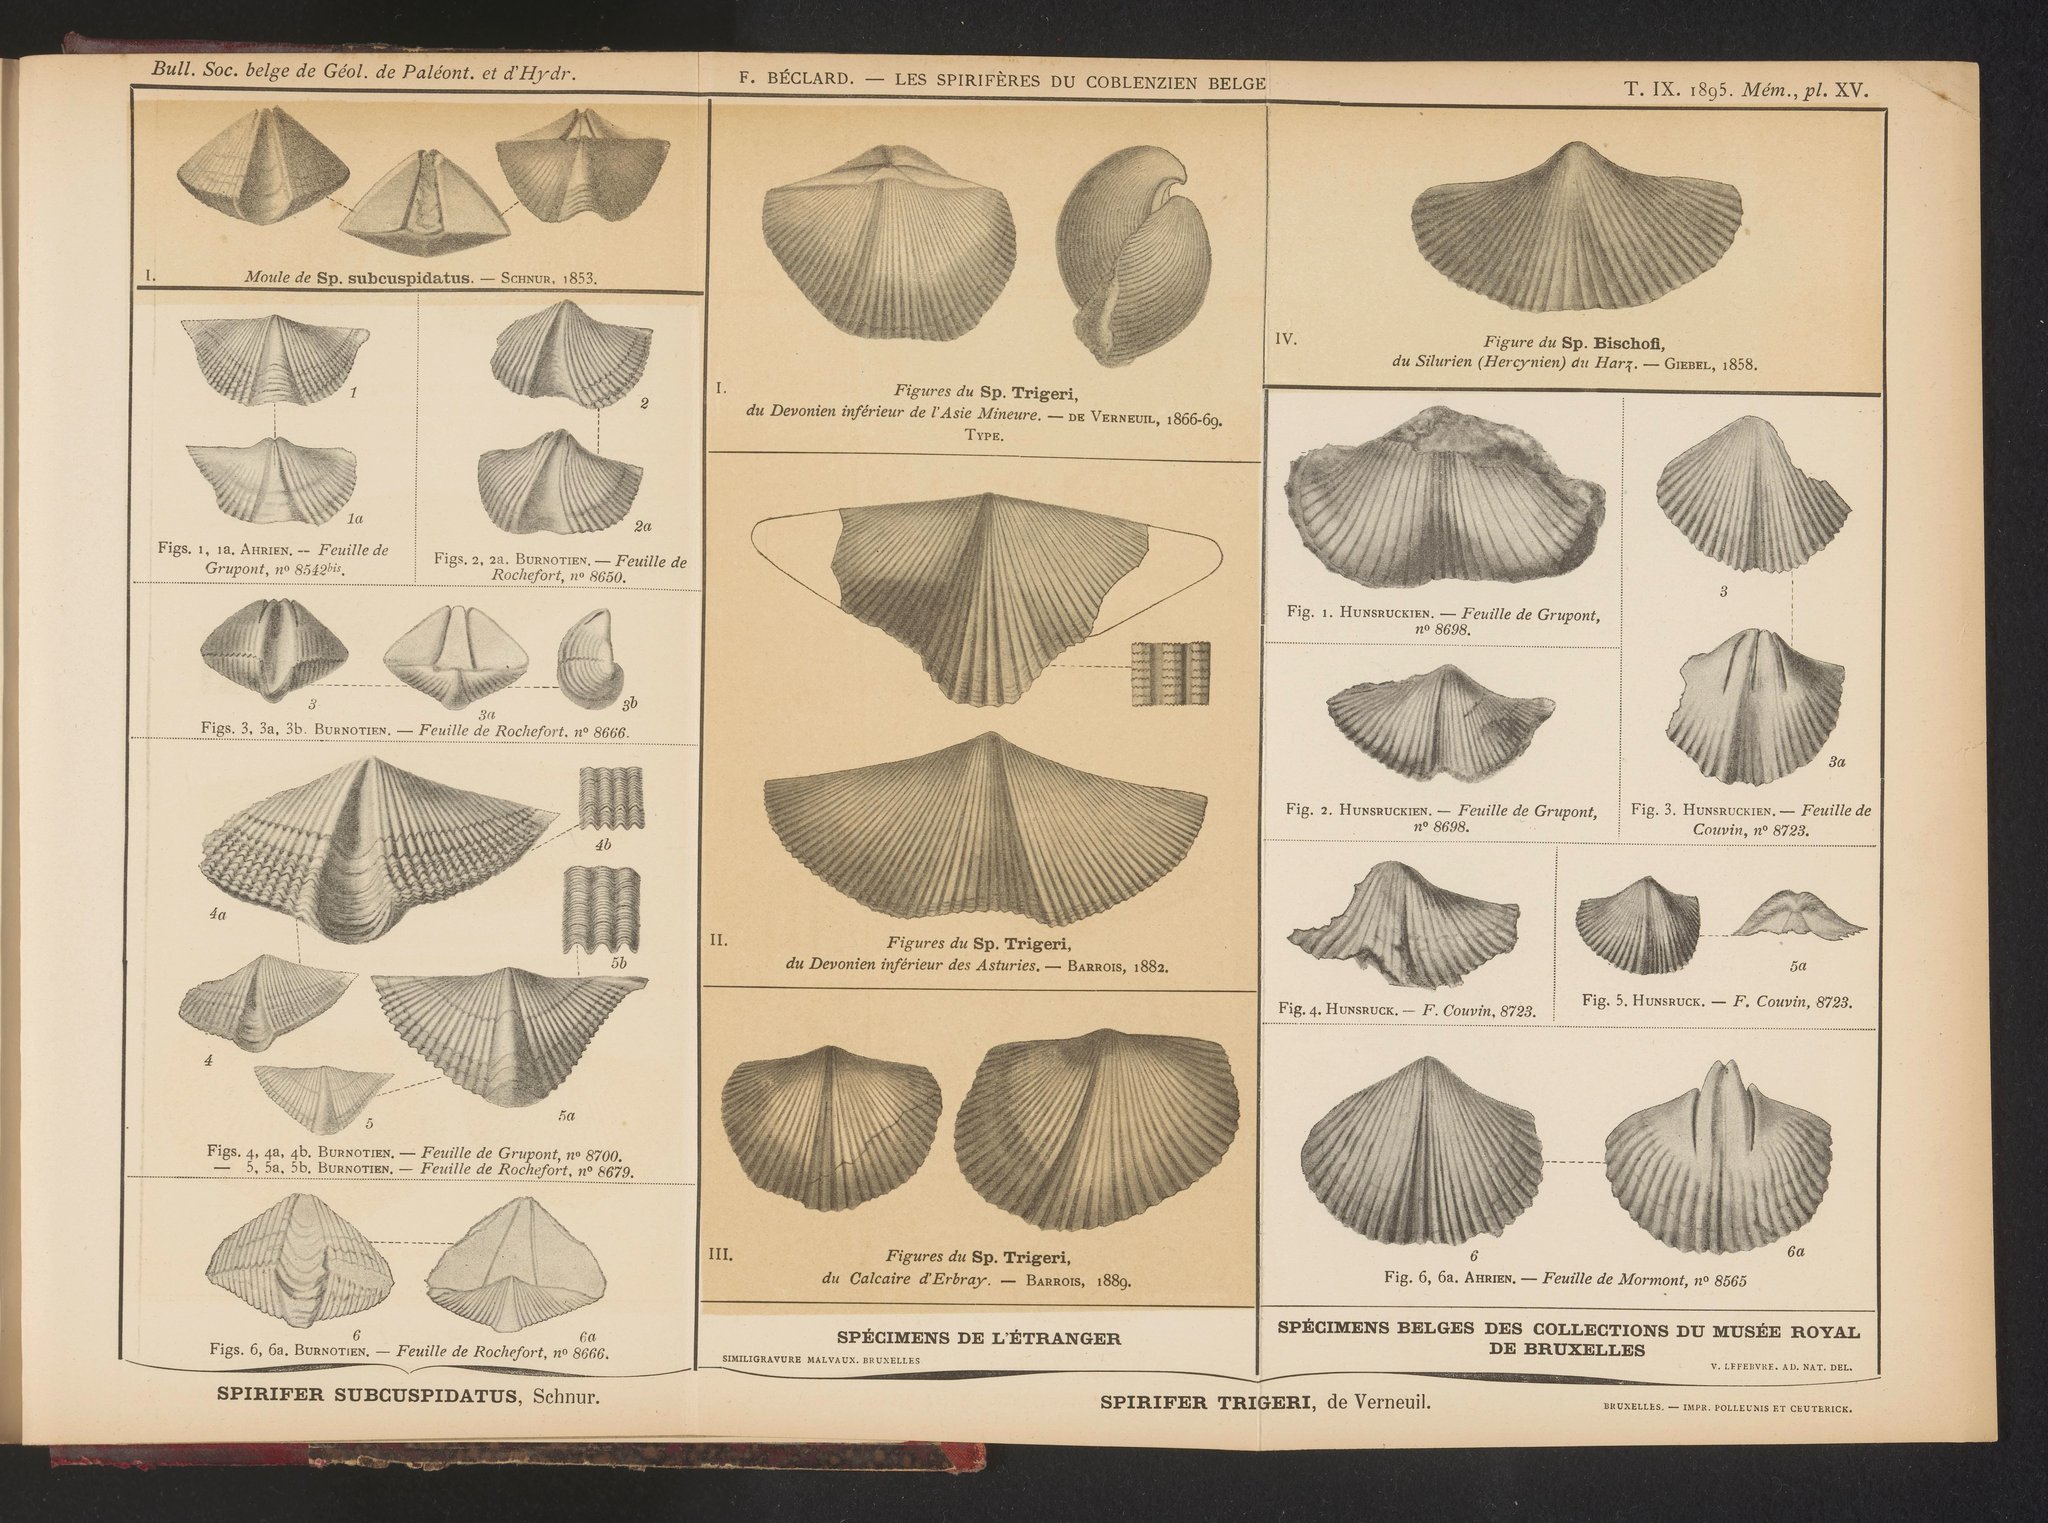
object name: photomechanical print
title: Verzameling gefossiliseerde armpotigen, Spirifer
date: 1889-1894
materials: paper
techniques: autotype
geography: brussels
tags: fossil animals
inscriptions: inscription: ‘Bull. Soc. belge de Géol. de Paléont. et d'Hydr./ F. Béclard. - les spirifères du coblenzien Belge/ T. IX 1895. Mém., pl. XV.’, inscription: ‘Spirifer subcuspidatus, Schnur/ Spirifer trigeri, de Verneuil.’, inscription: ‘V. Lefebvre. AD. NAT. DEL.’